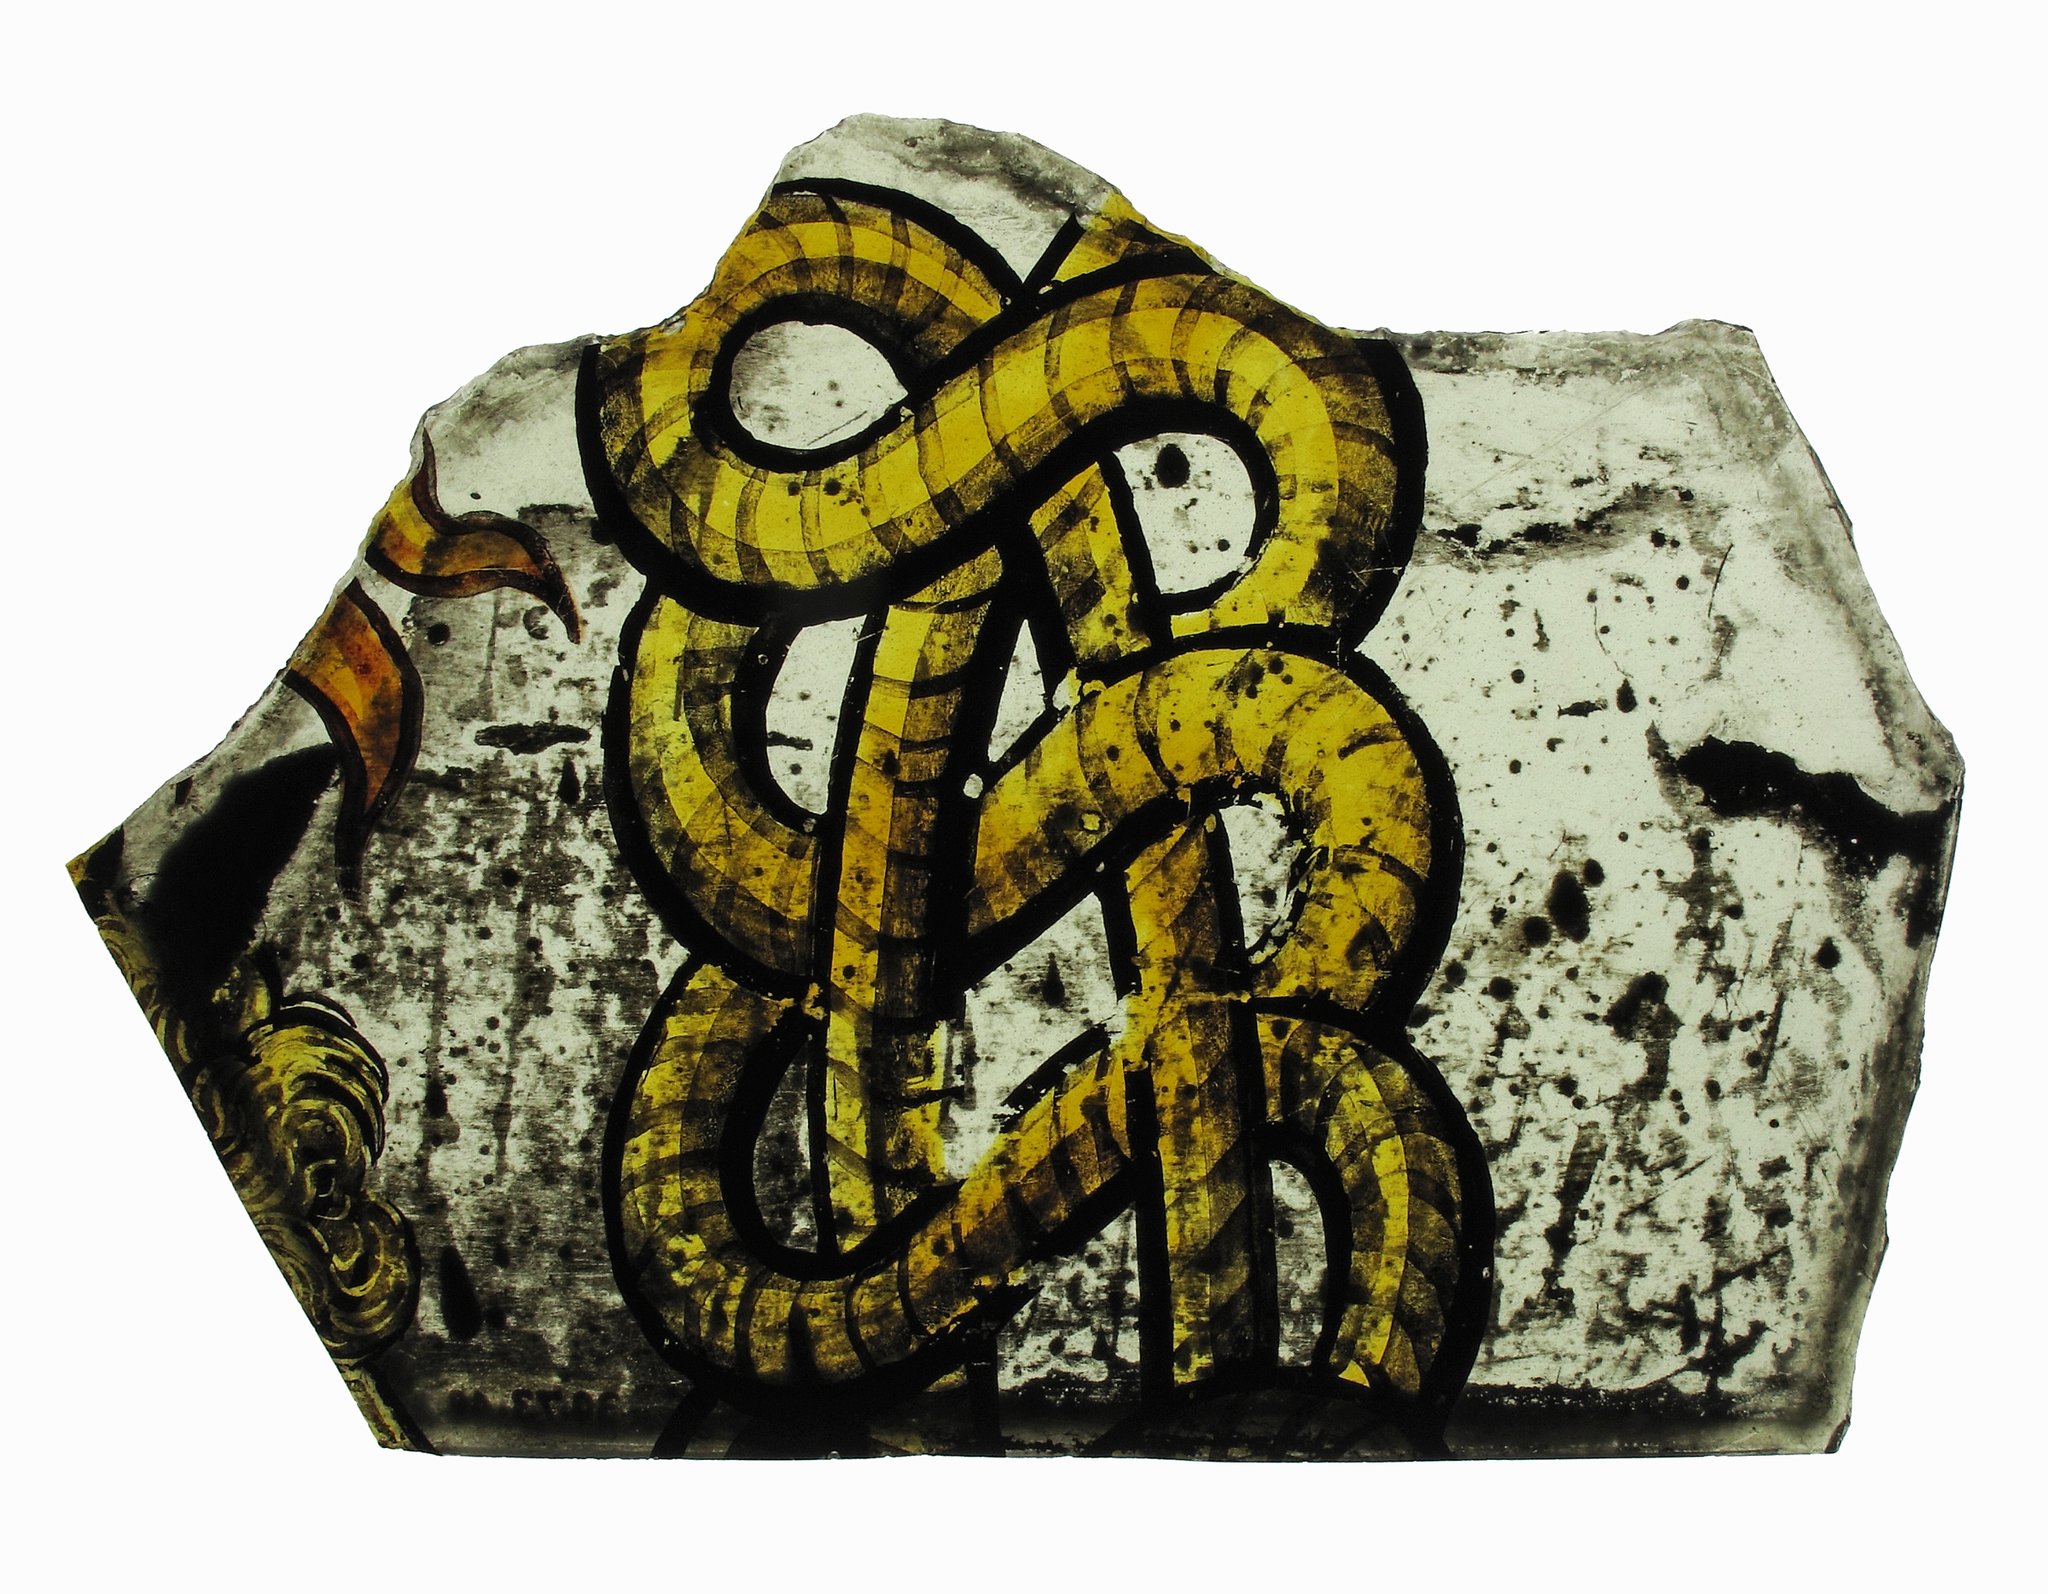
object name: fragment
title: Glass Fragment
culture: european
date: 1401-1600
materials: glass